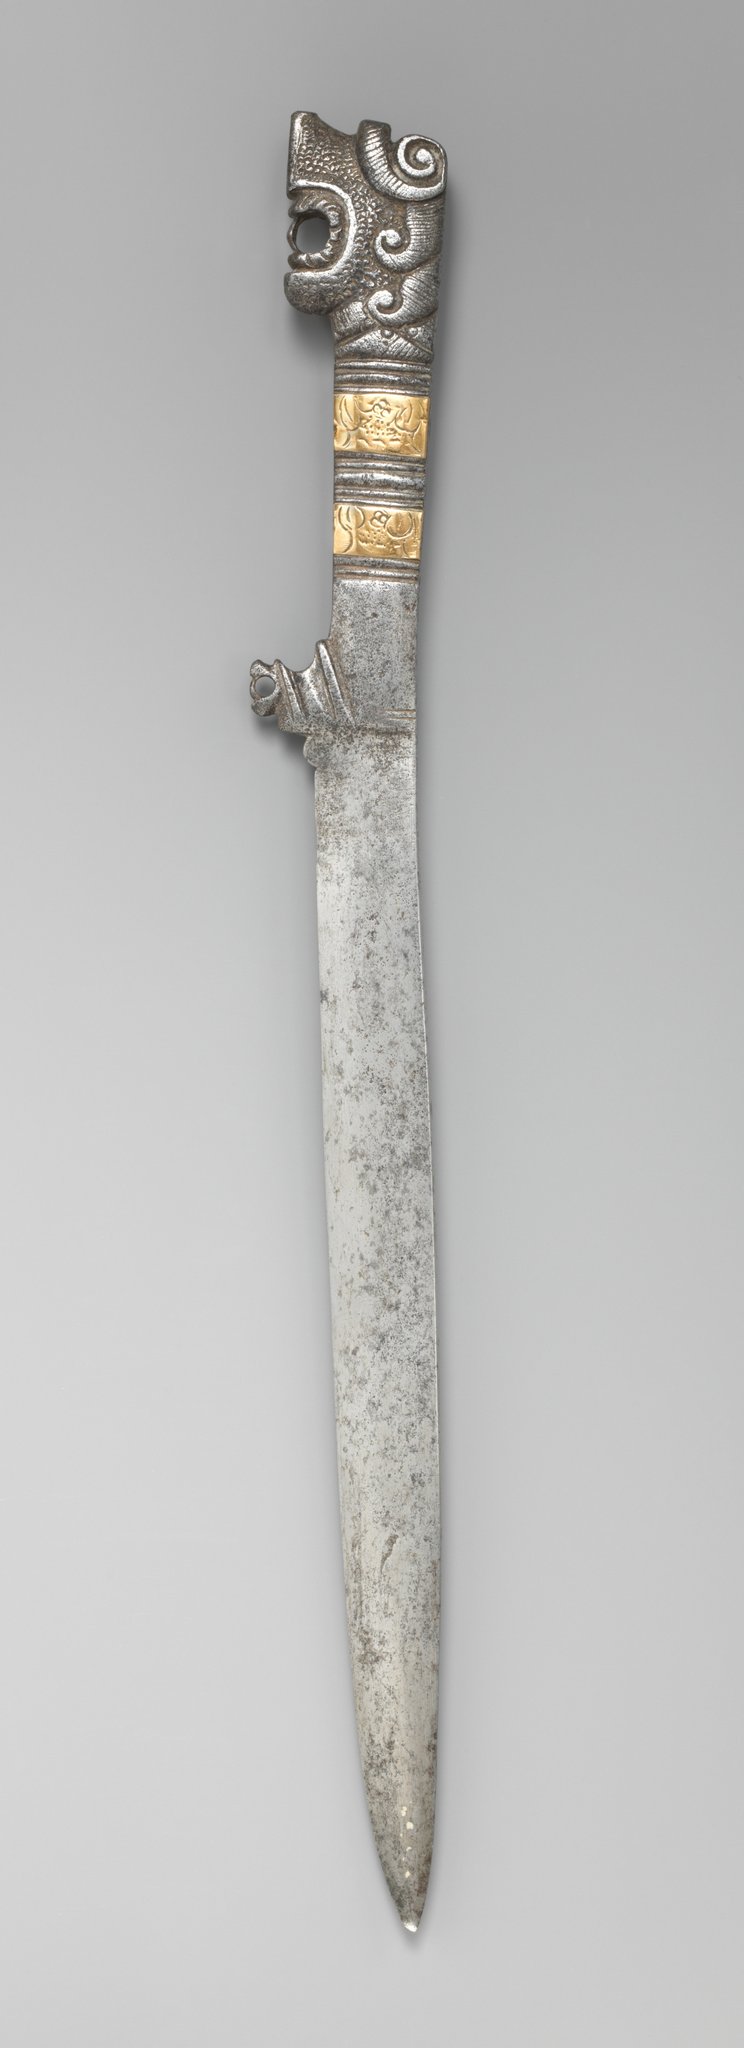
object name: knife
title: Carving knife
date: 1601-1700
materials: gold, metal, steel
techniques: gilding